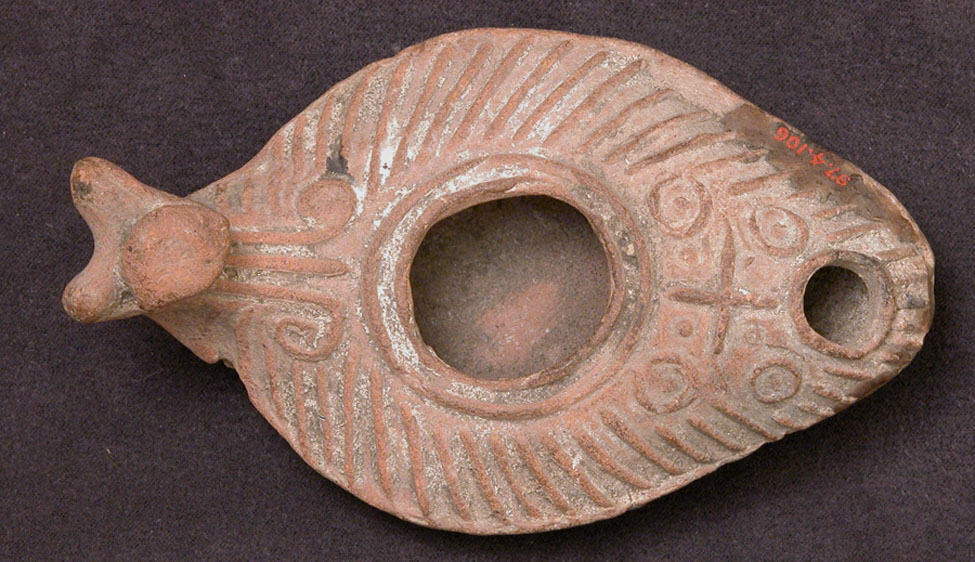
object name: lamp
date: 501-700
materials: earthenware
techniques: molding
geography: egypt